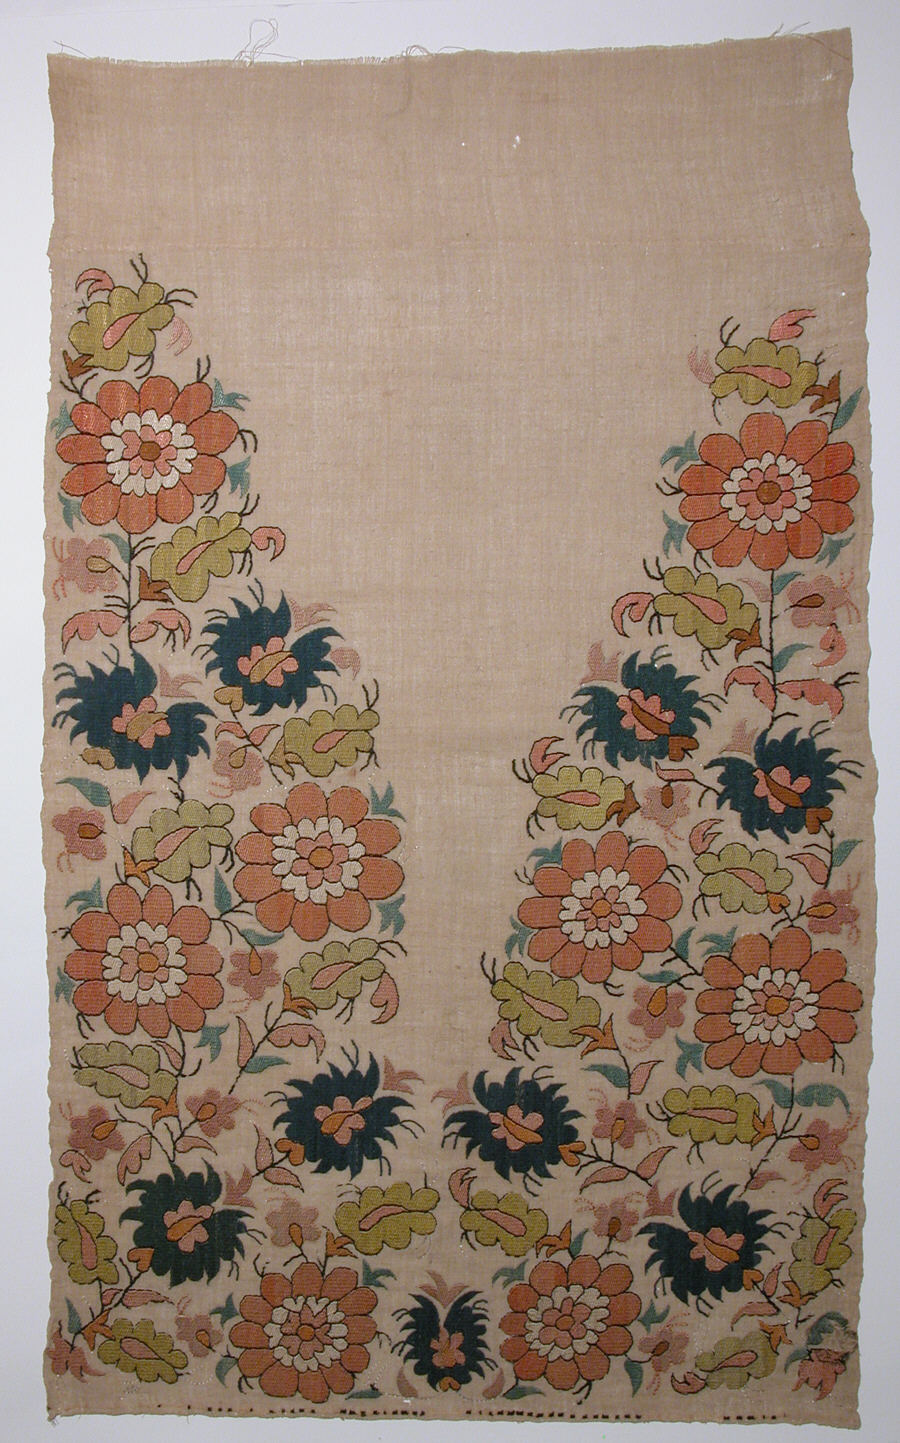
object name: towel end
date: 1767-1800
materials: linen, metal thread, silk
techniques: embroidery, weave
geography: turkey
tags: flowers